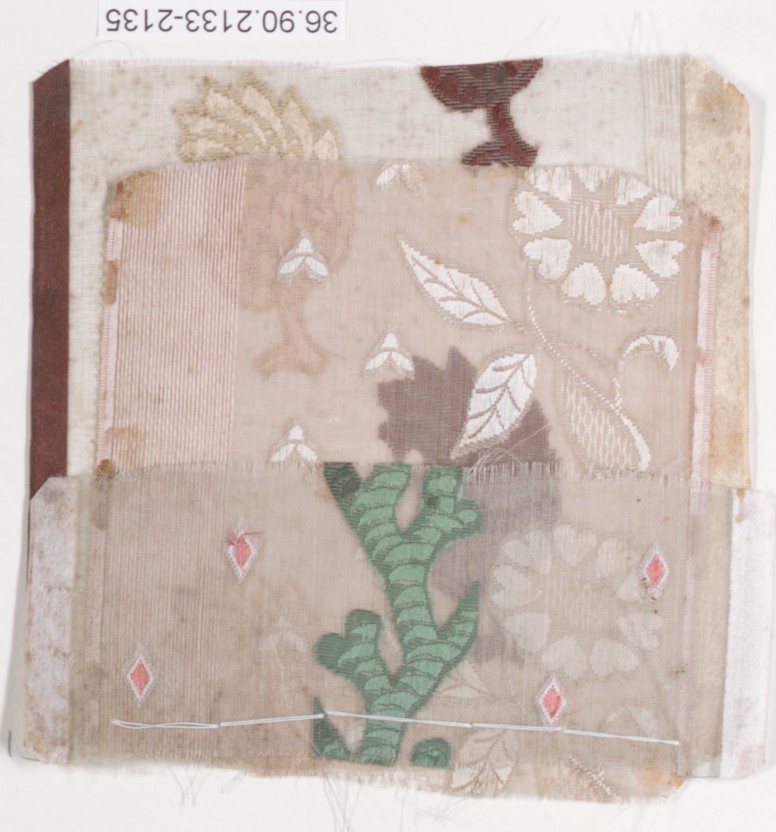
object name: piece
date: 1801-1900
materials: silk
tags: flowers,leaves